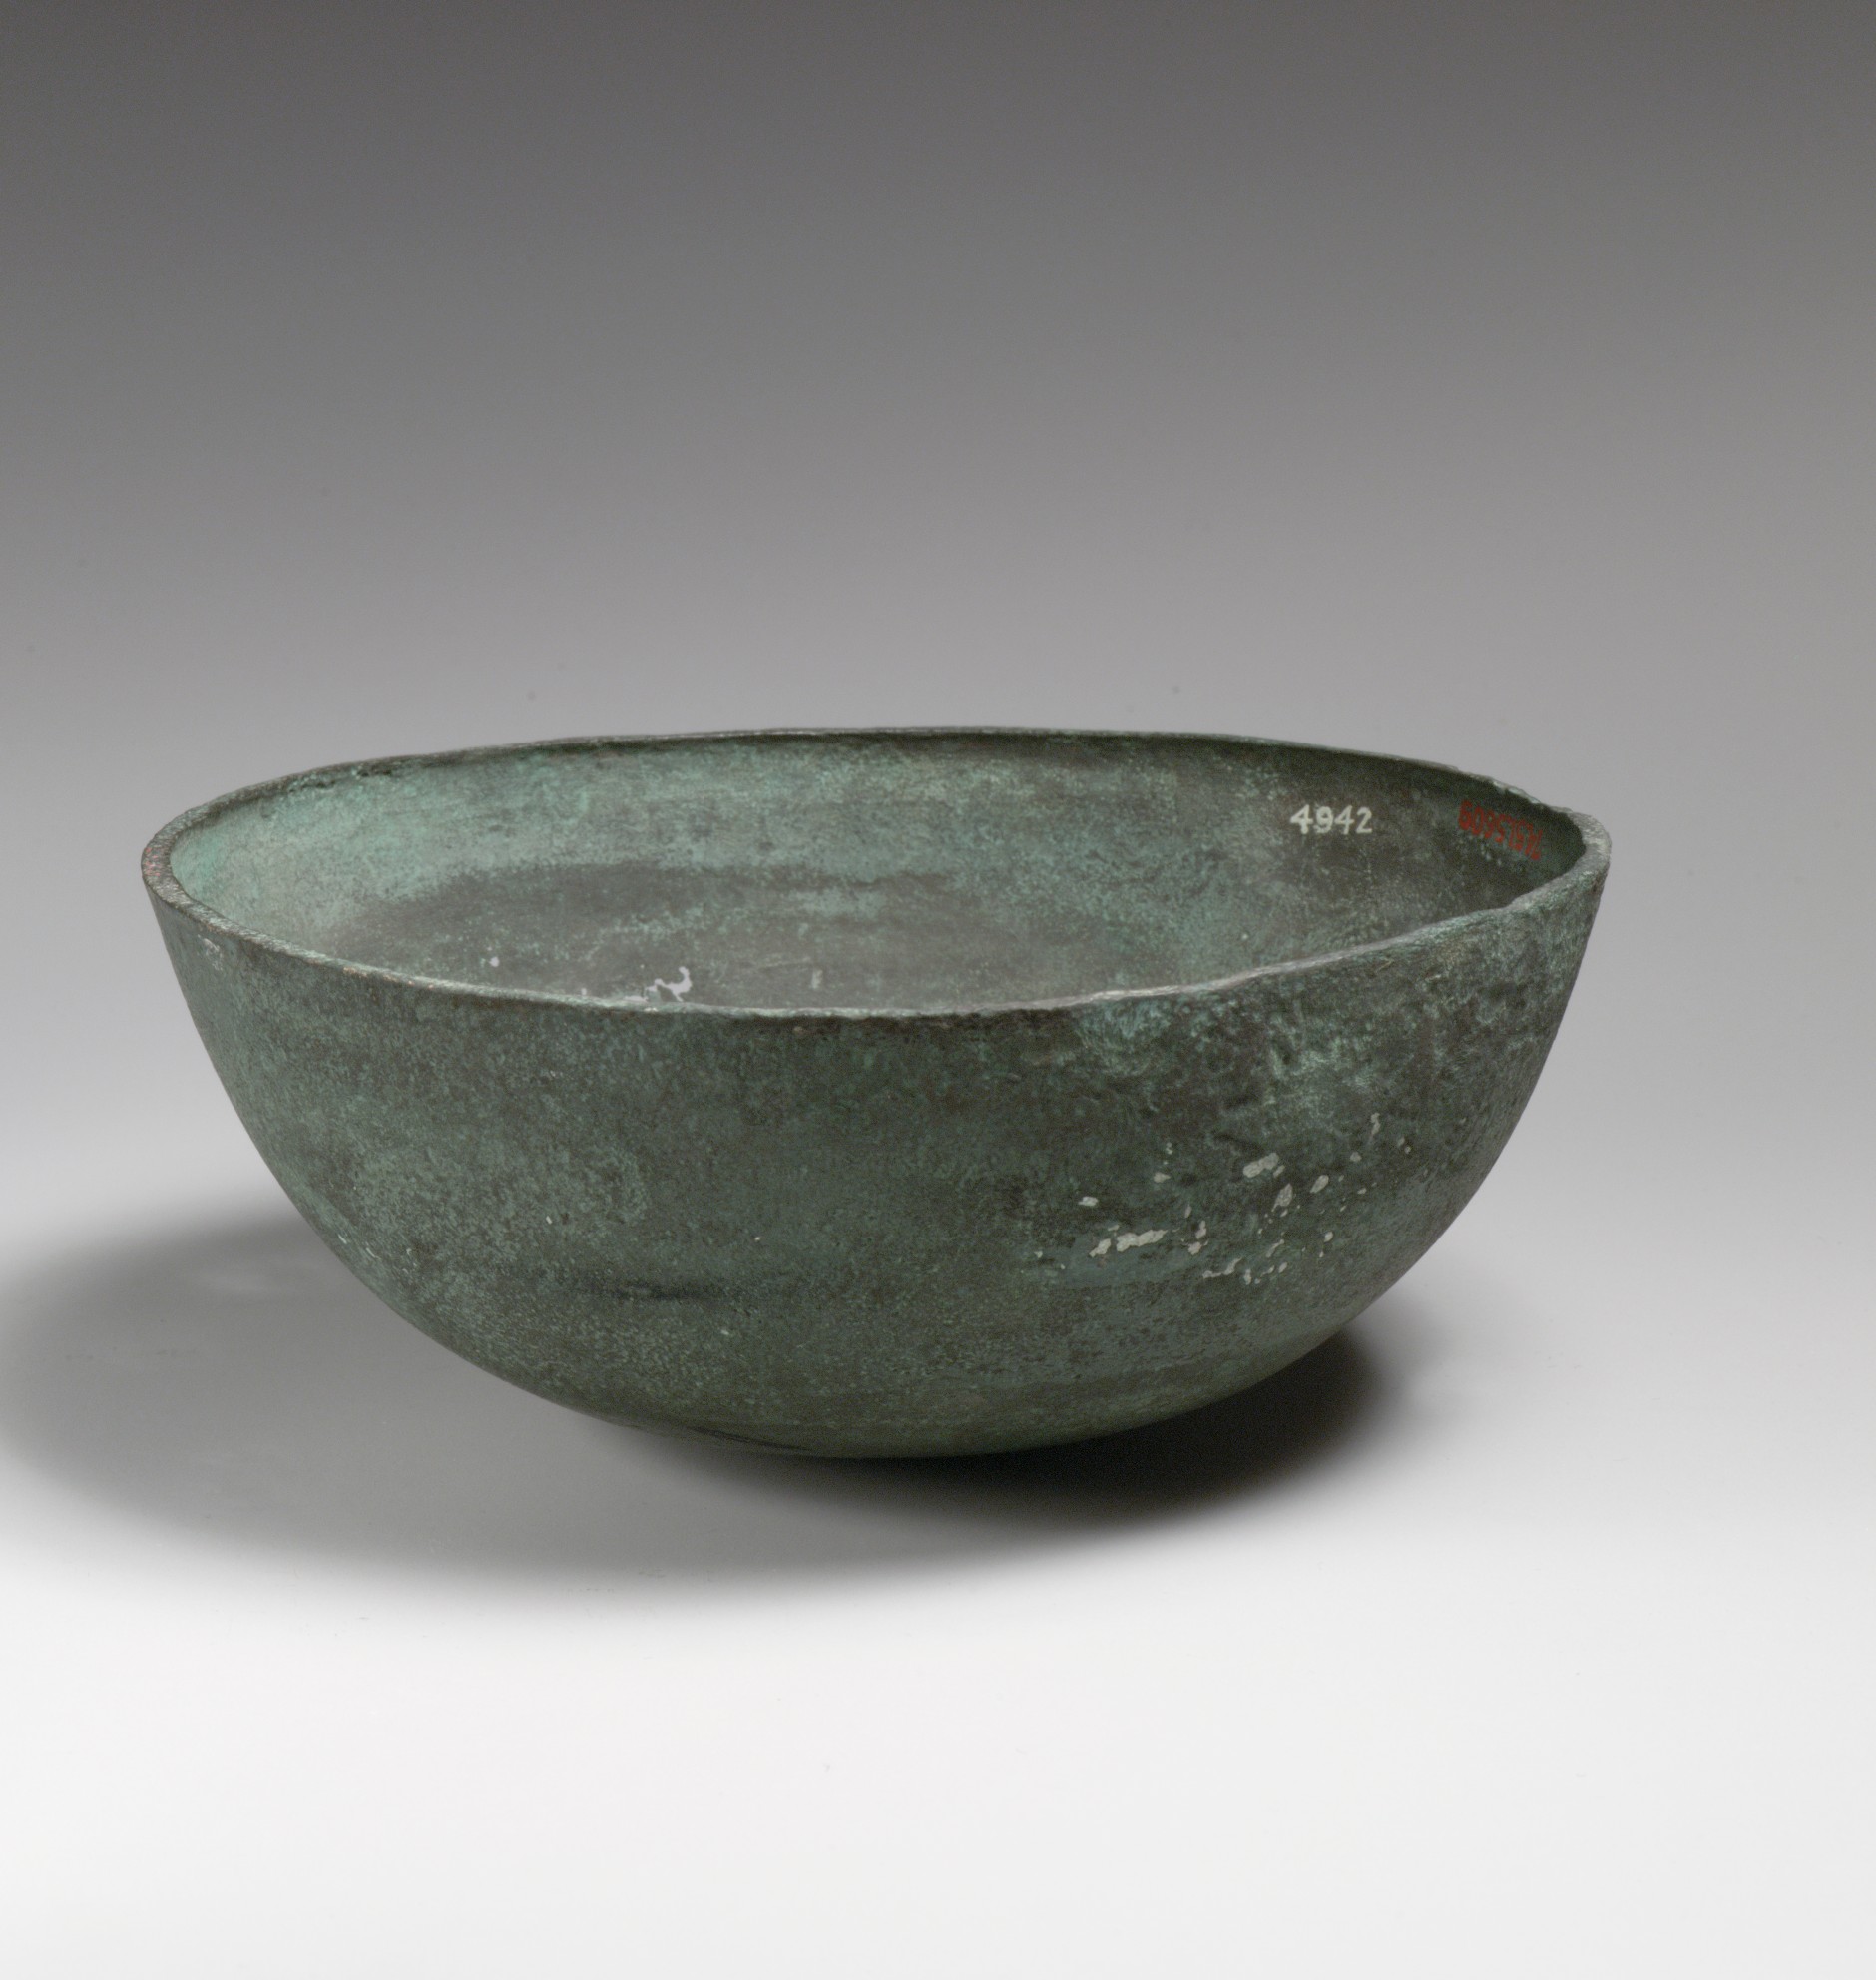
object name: bowl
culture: cypriot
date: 3900 BCE-100 CE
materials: bronze